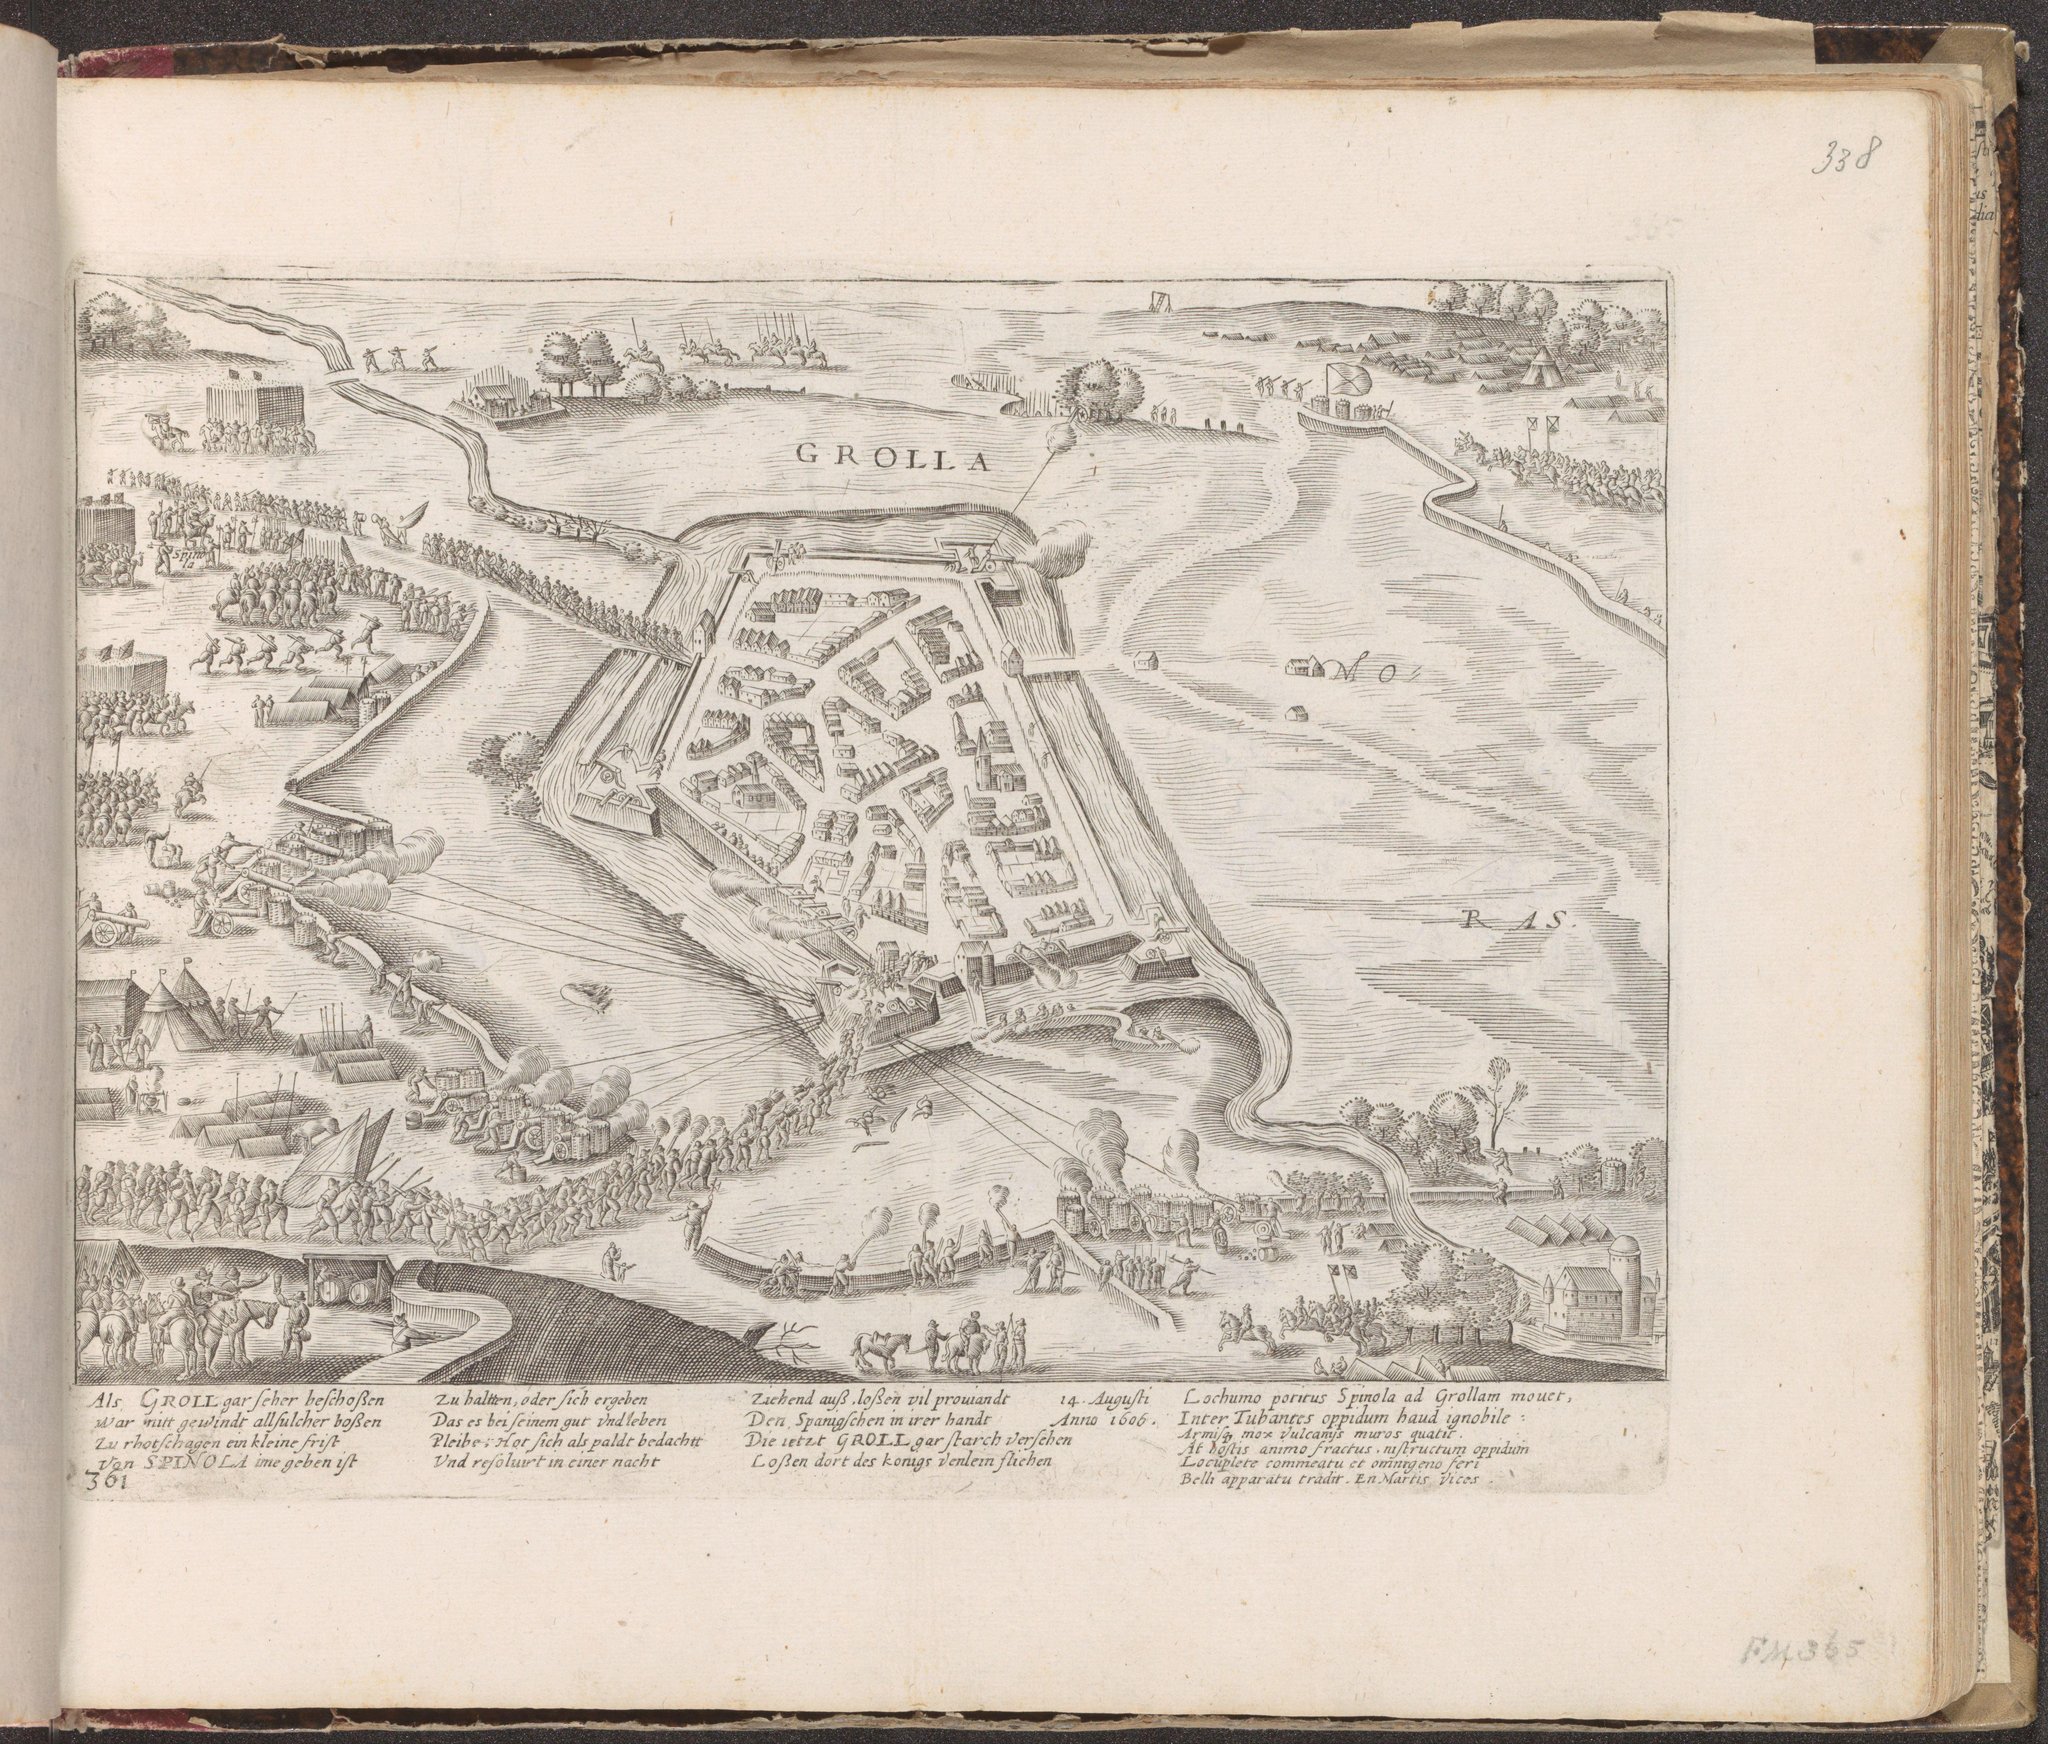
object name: print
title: Inname van Grol door Spinola, 1606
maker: frans hogenberg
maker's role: print maker, publisher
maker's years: 1538-1590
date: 1606-1608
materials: paper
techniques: etching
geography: cologne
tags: capture of city (after the siege)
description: Inname van Grol (Groenlo) door het leger van Spinola, 14 augustus 1606. Gezicht op de stad en de beschietingen door het Spaanse leger. Met onderschrift van 12 regels in het Duits en 6 regels in het Latijn. Linksonder genummerd: 361. De prent maakt deel uit van een album.